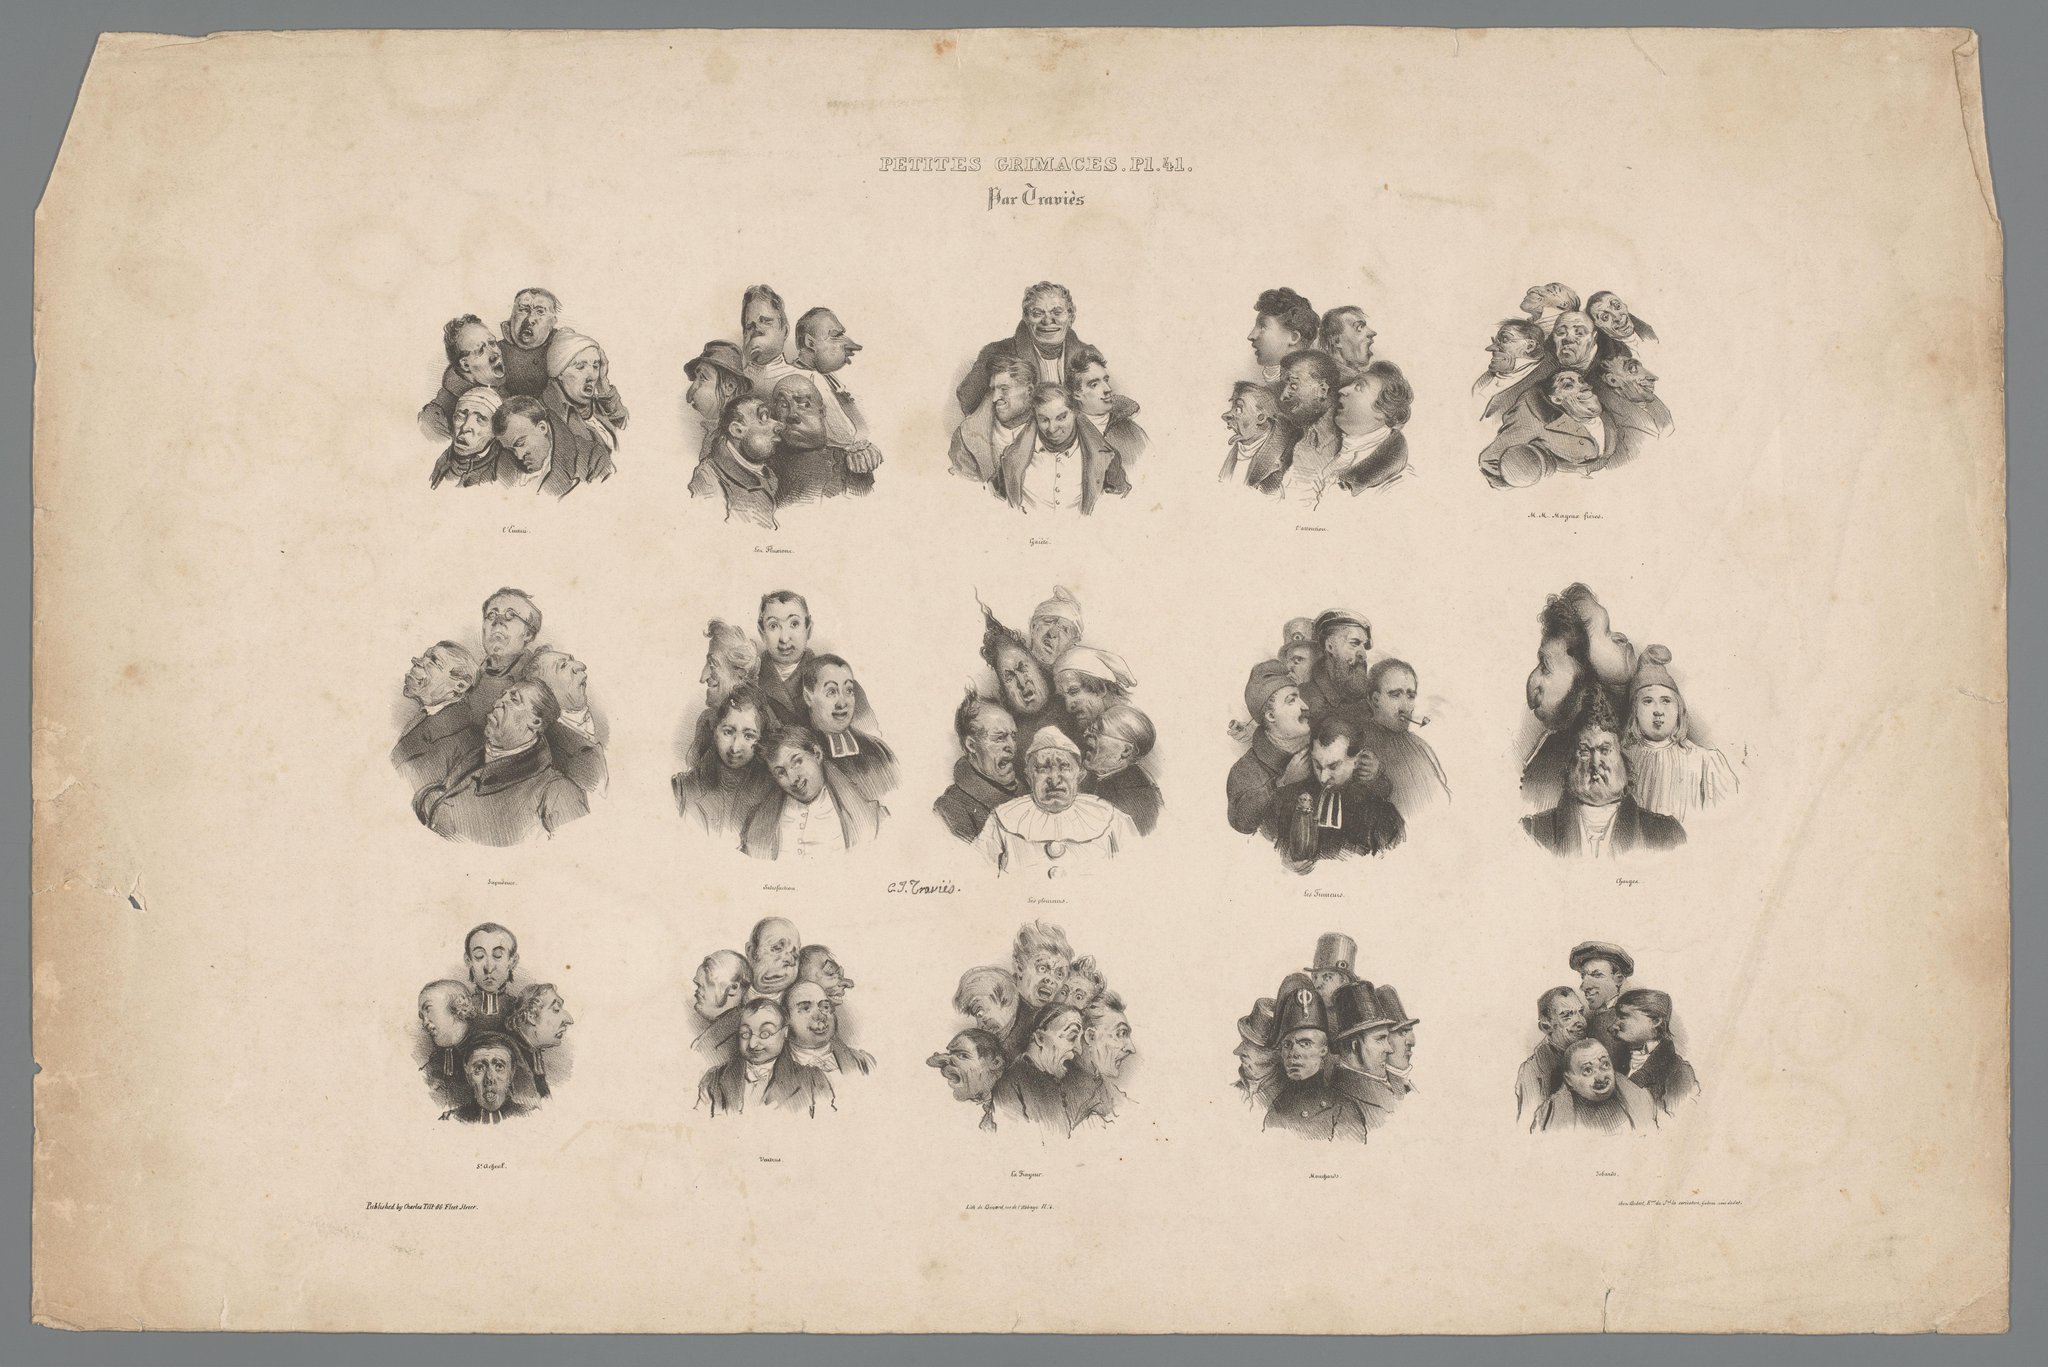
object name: print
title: Kleine grimassen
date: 1832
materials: paper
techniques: lithograph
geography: paris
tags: adult man, laughing